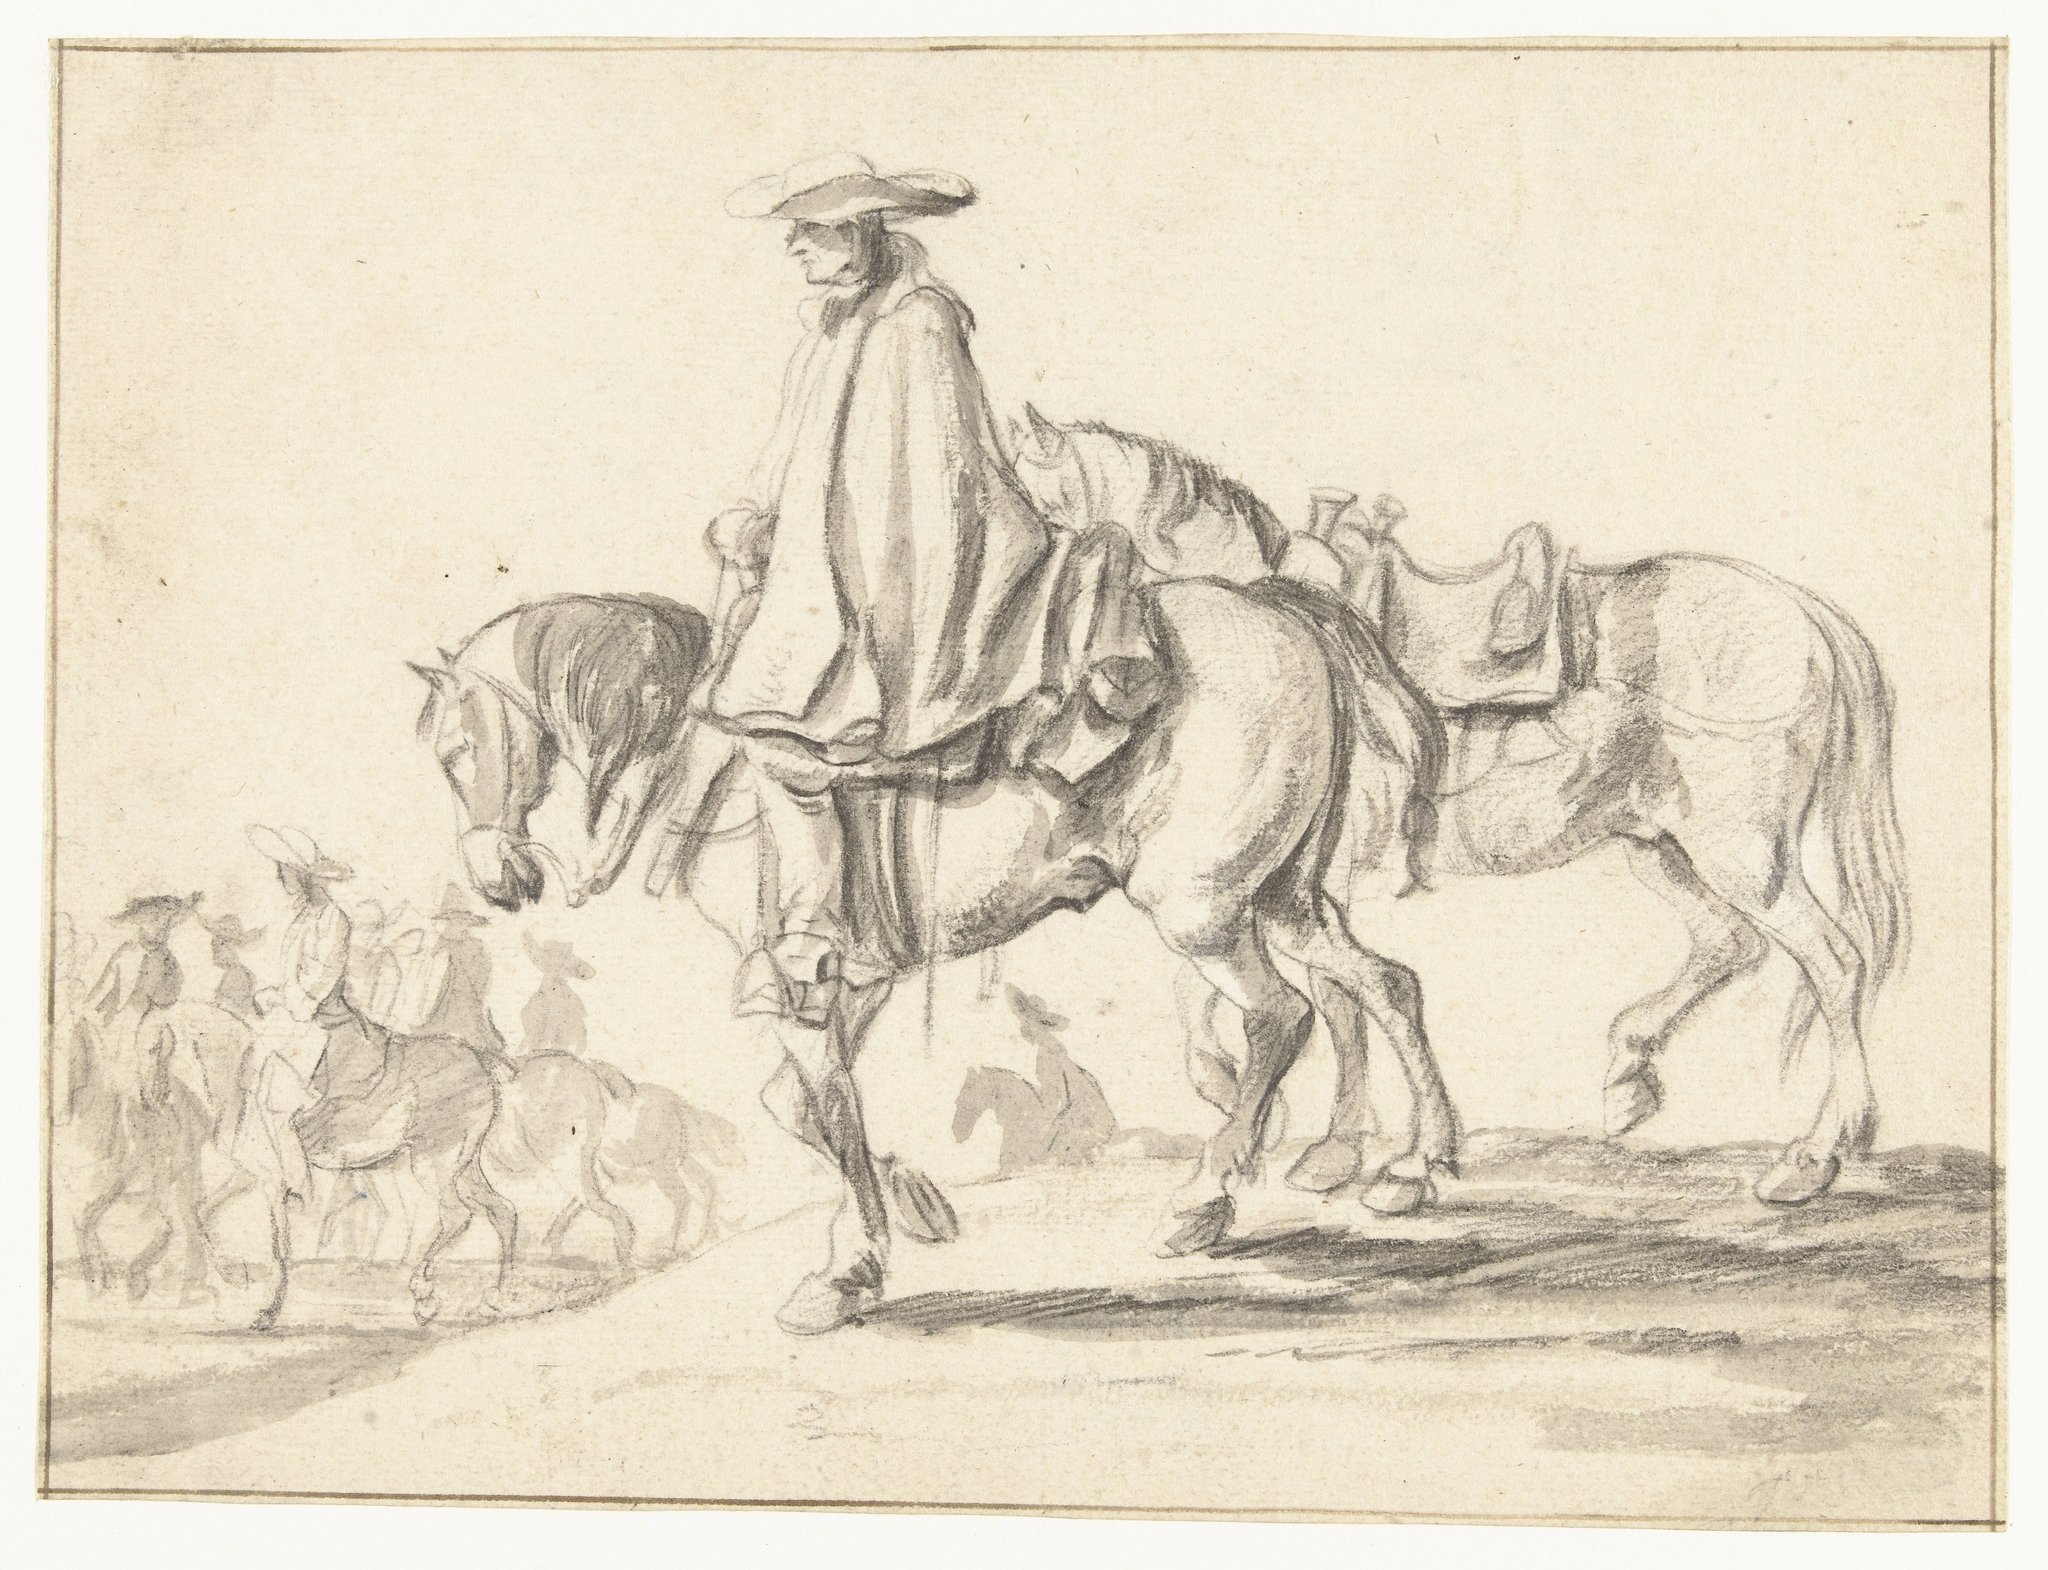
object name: drawing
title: Een ruiter met een grote hoed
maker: adam frans van der meulen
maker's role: draughtsman, painter, publisher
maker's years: 1632-1690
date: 1642-1690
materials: chalk, paper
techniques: brush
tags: riding a horse, ass, or mule; rider, horseman, horse